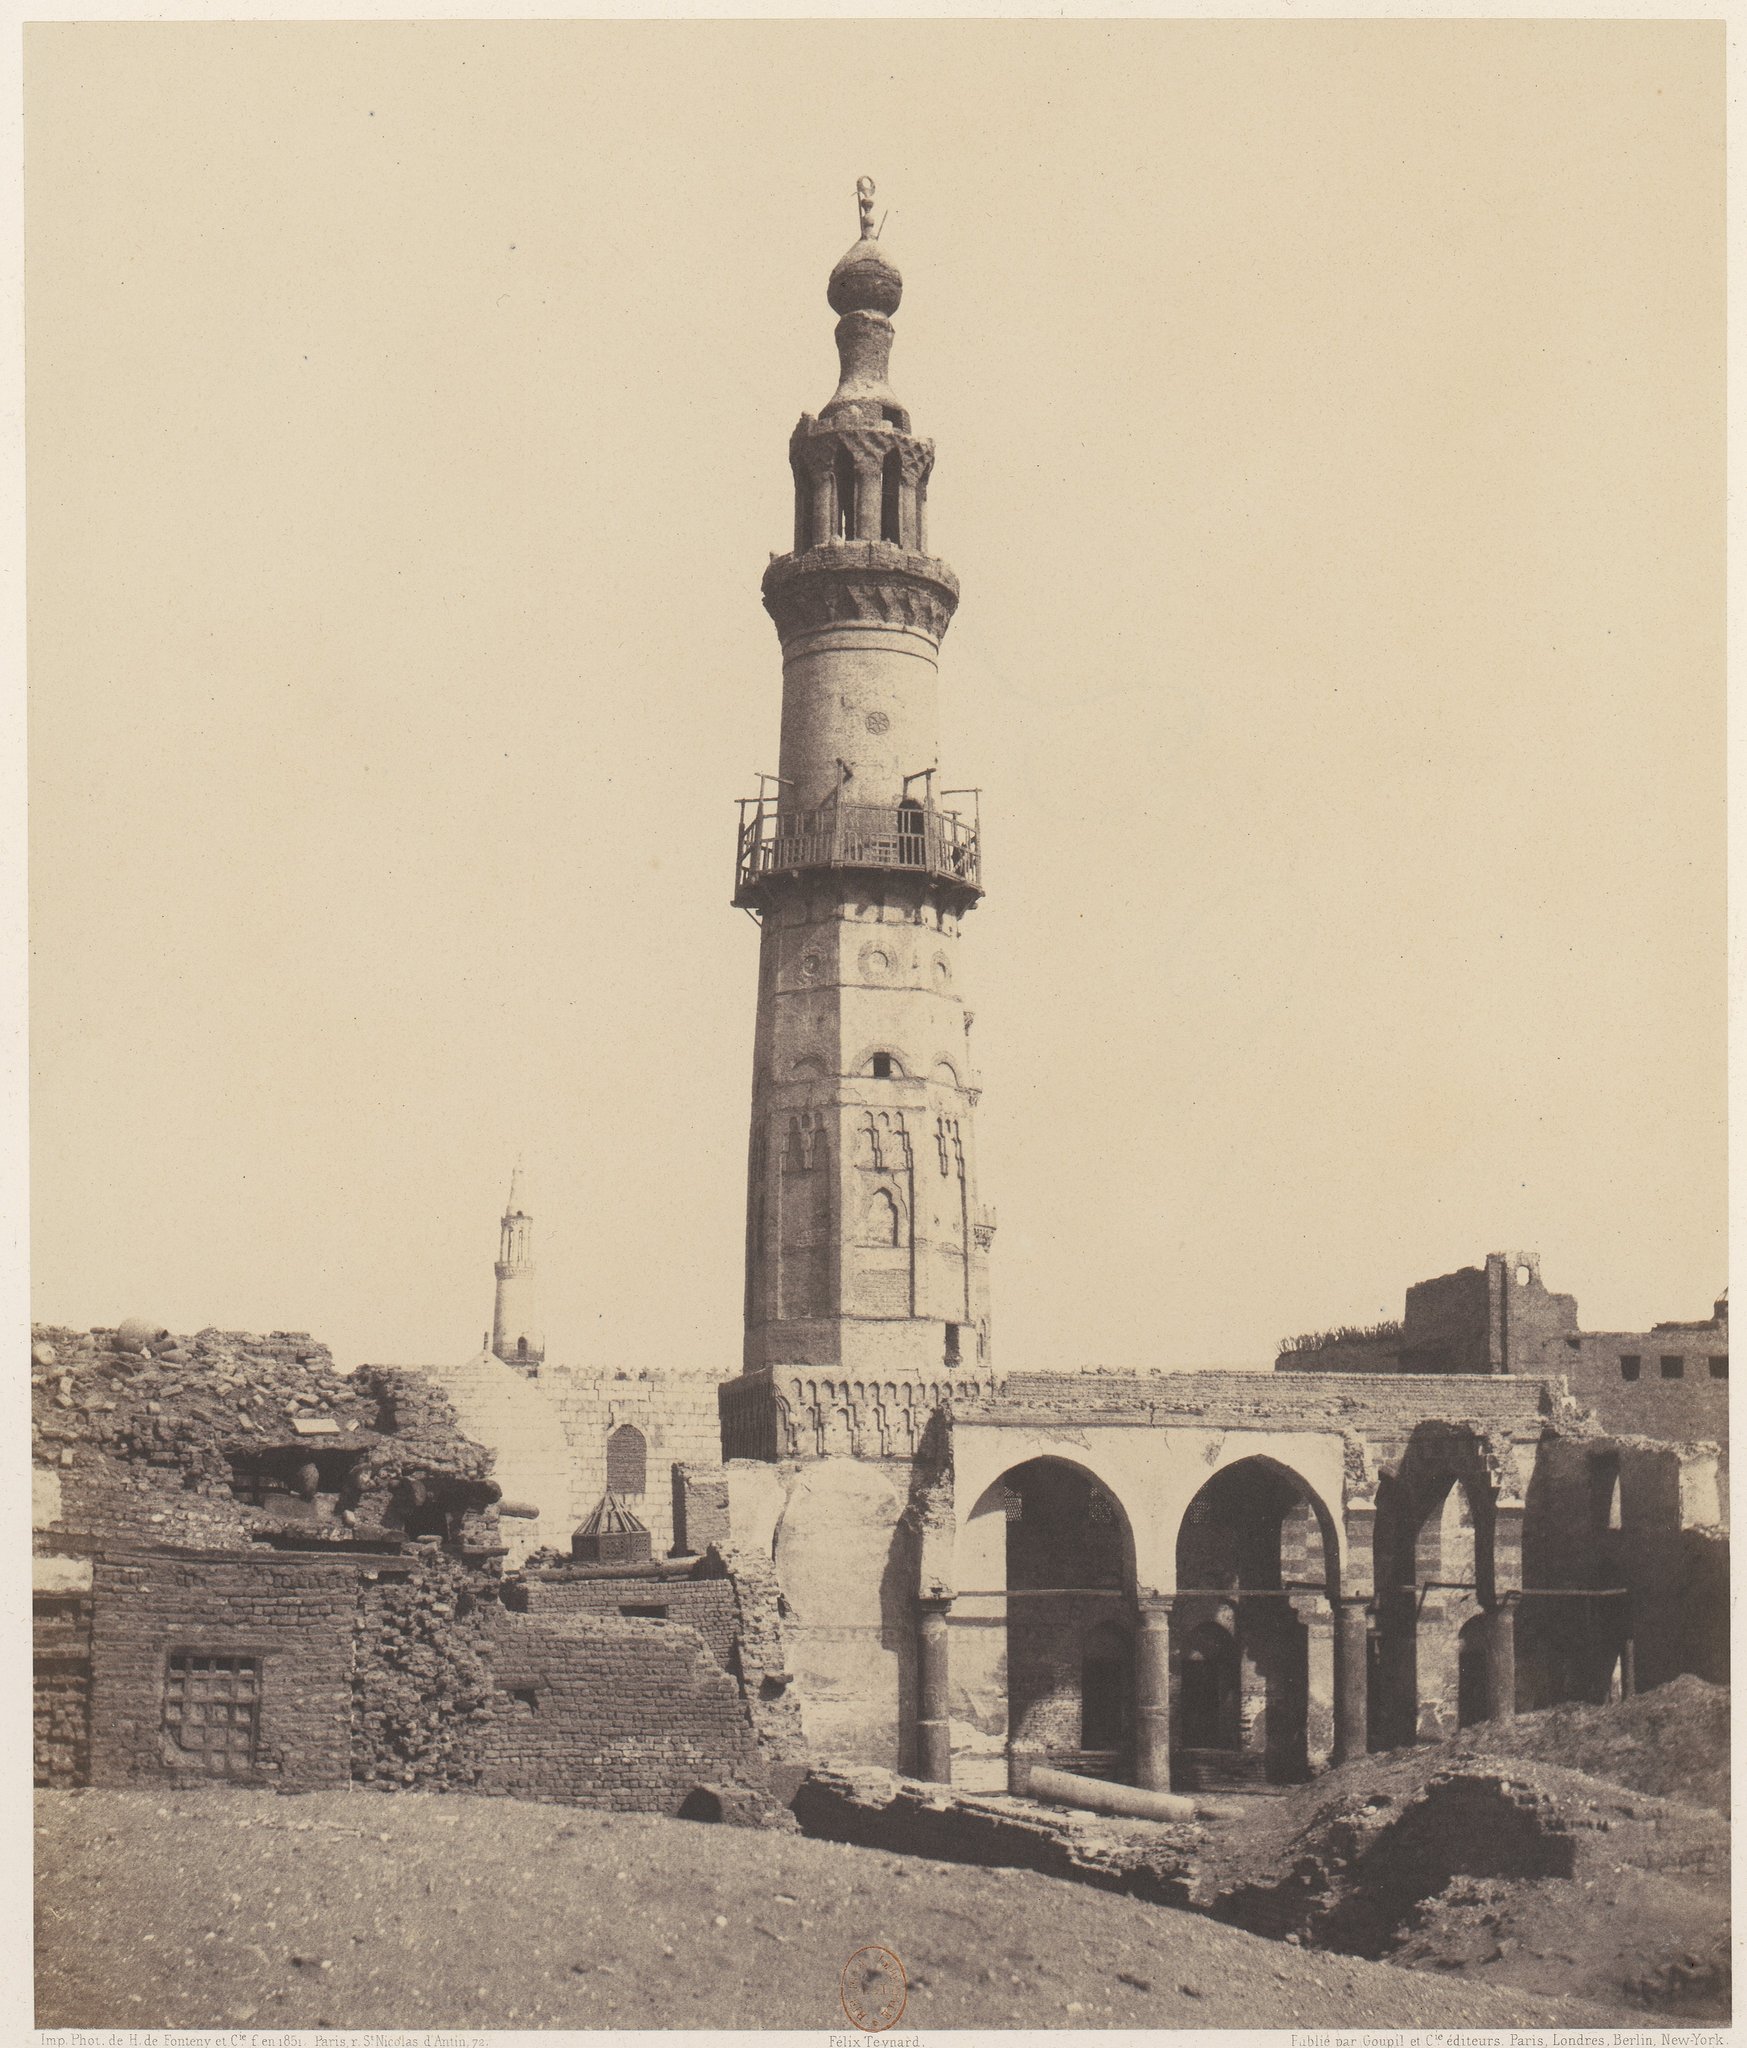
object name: photograph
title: Djirdjeh, Mosquée en Ruines Sur le Bord du Nil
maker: félix teynard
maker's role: artist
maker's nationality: french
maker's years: 1817-1892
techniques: paper negative, salted paper print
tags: architecture,towers,mosques